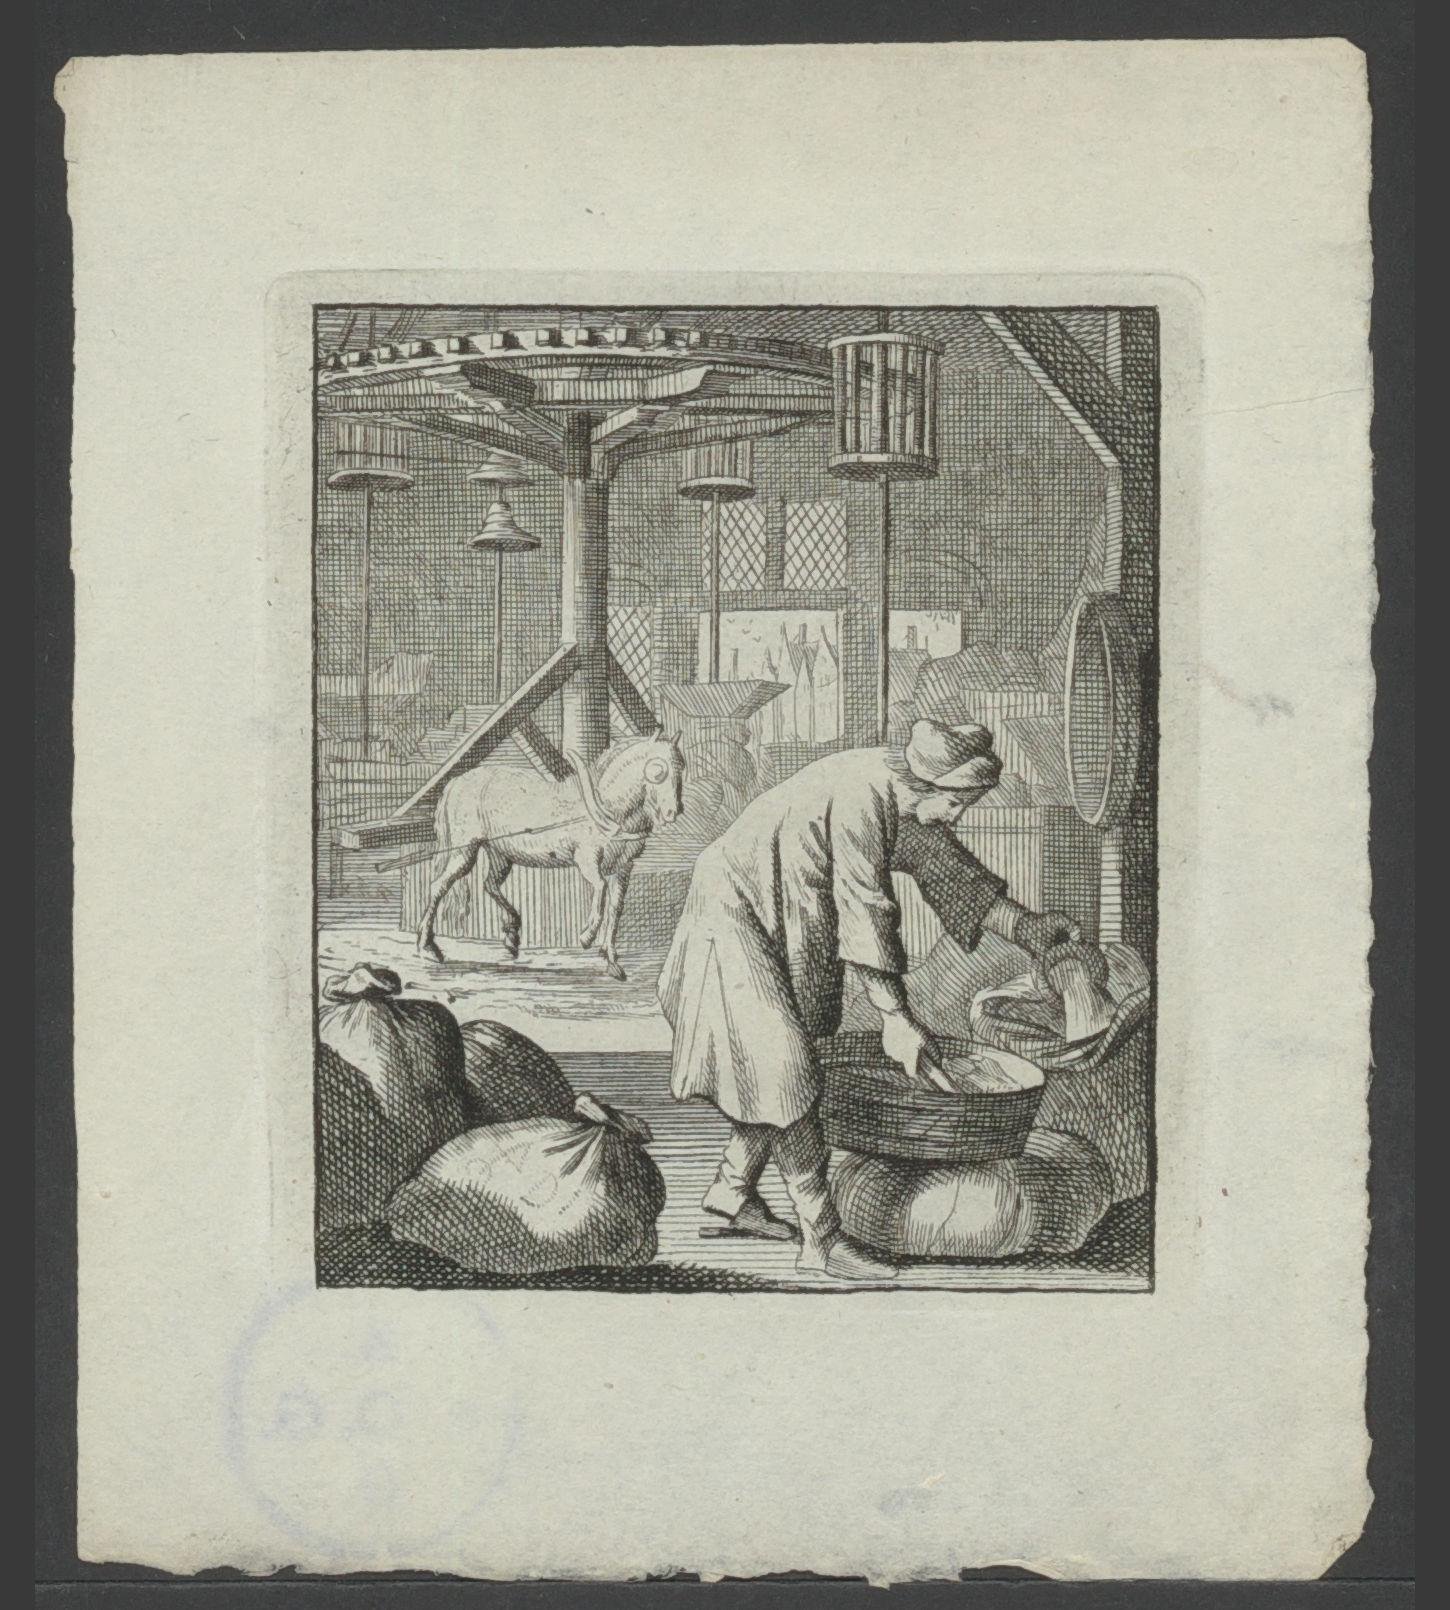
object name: print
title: Gruttenmaker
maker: Anonymous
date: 1694-1799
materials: paper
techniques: engraving, etching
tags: flour- and grain-products, handicrafts, craftsman at work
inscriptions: collector's mark: Lugt 1641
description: Onderwerpsrubrieken binnen de Atlas Zeden en Gewoonten: Handel, Nijverheid en Verkeer, Beroep en bedrijf, Complete suites.